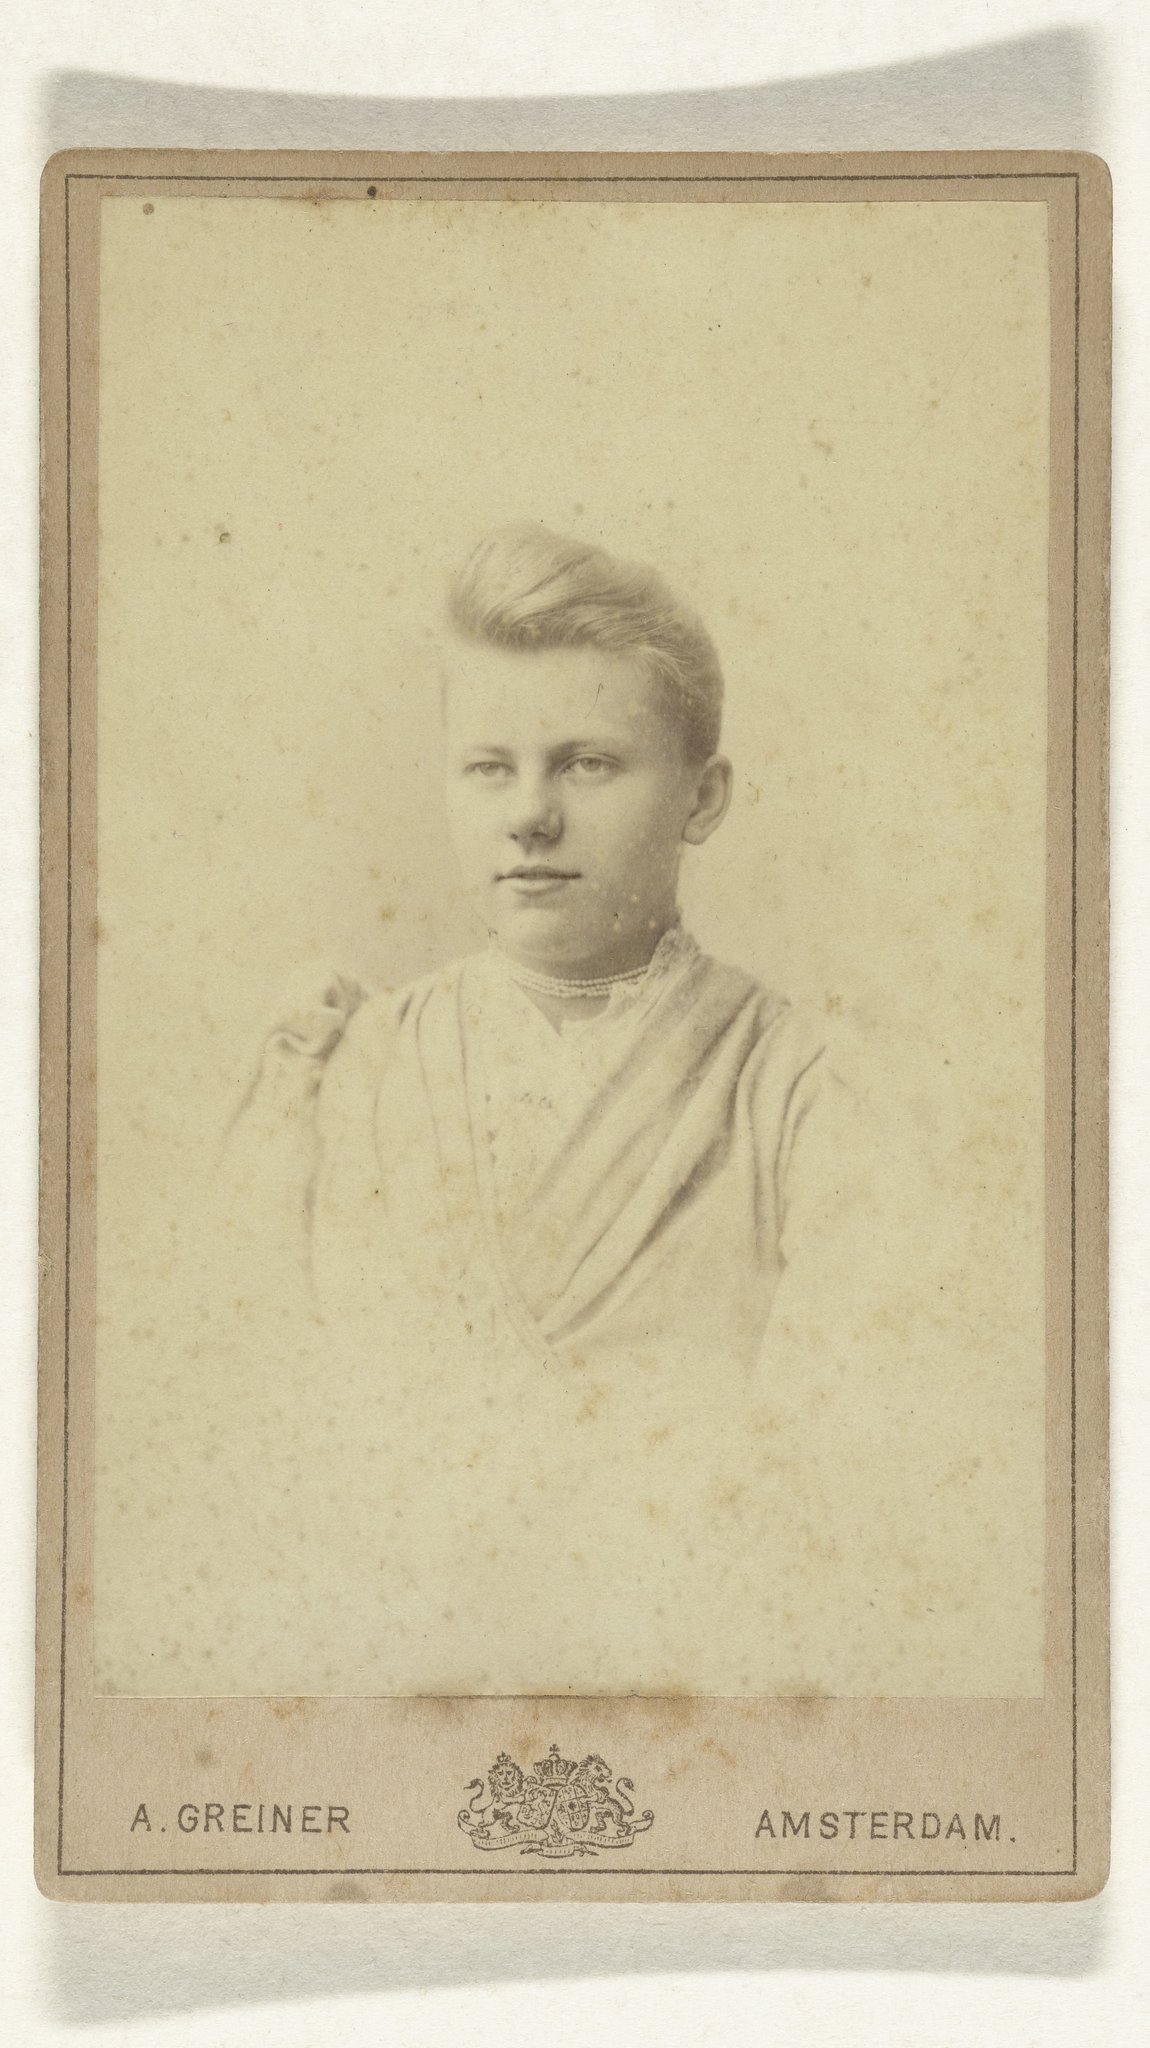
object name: carte de visite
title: Studioportret van een jonge vrouw met parelsnoer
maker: albert greiner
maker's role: fotograaf, fotostudio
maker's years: 1833-1890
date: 1890-1915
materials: paper, photographic support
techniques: photography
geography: amsterdam